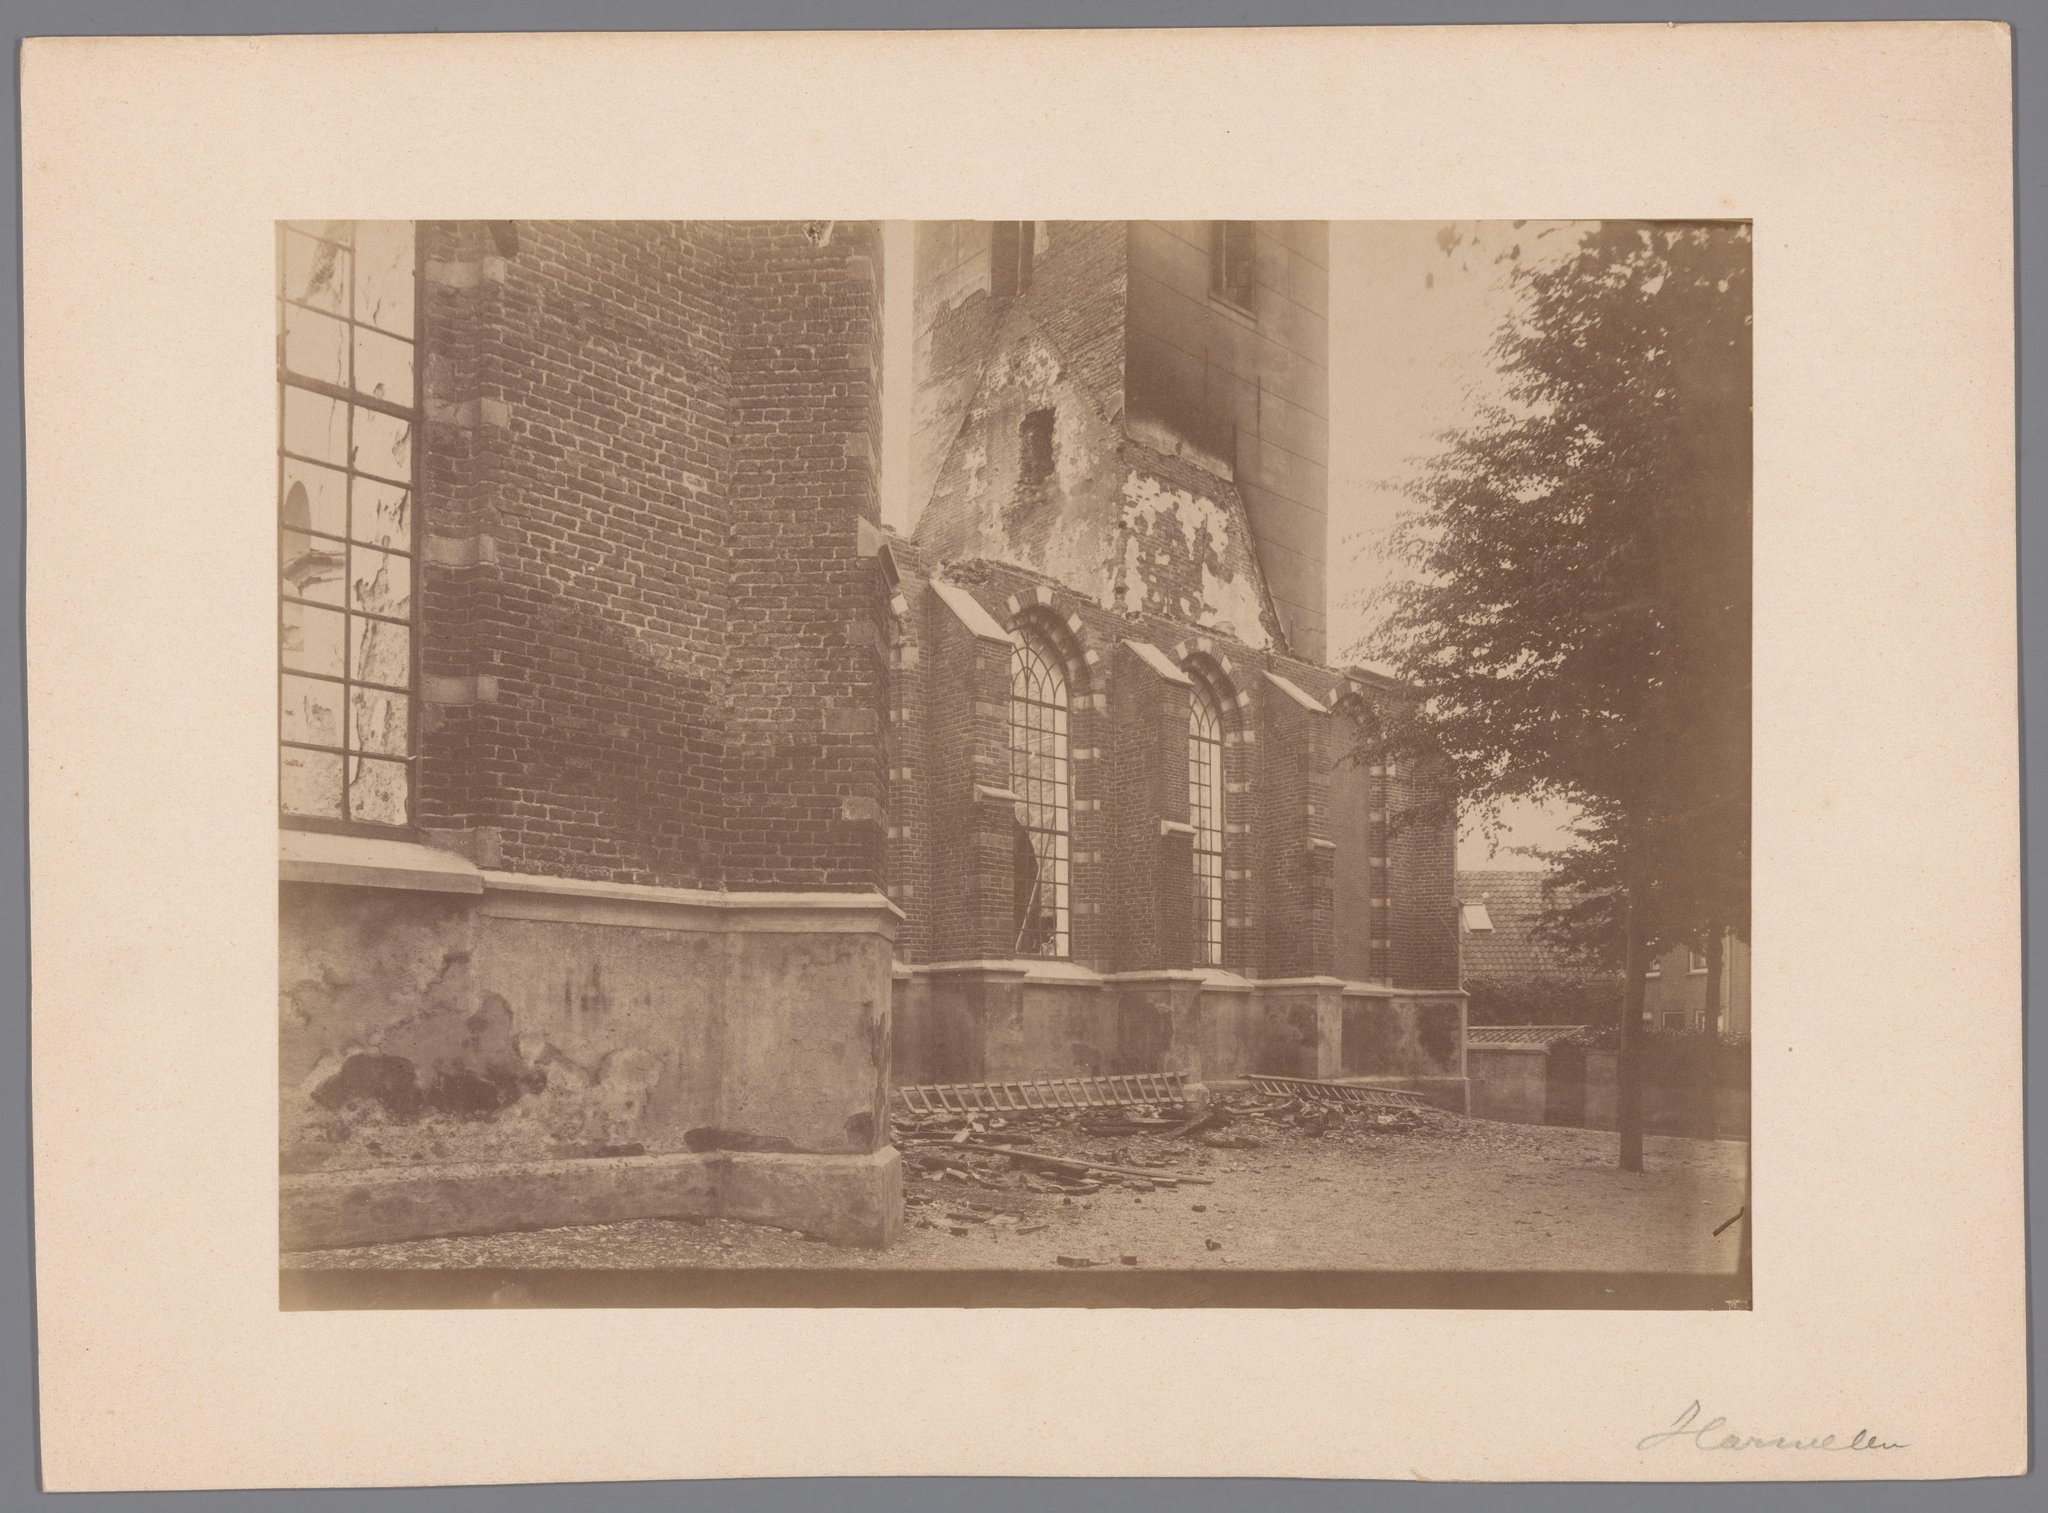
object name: photograph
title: Detail van de afgebrande Hervormde Kerk te Harmelen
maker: anoniem (monumentenzorg)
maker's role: fotograaf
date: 1900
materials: cardboard, photographic support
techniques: albumen print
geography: harmelen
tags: church (exterior)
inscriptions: annotation: ‘Kerk der N.H. gemeente te Harmelen (U.)/ na den brand juni 1900’, annotation: ‘Harmelen’